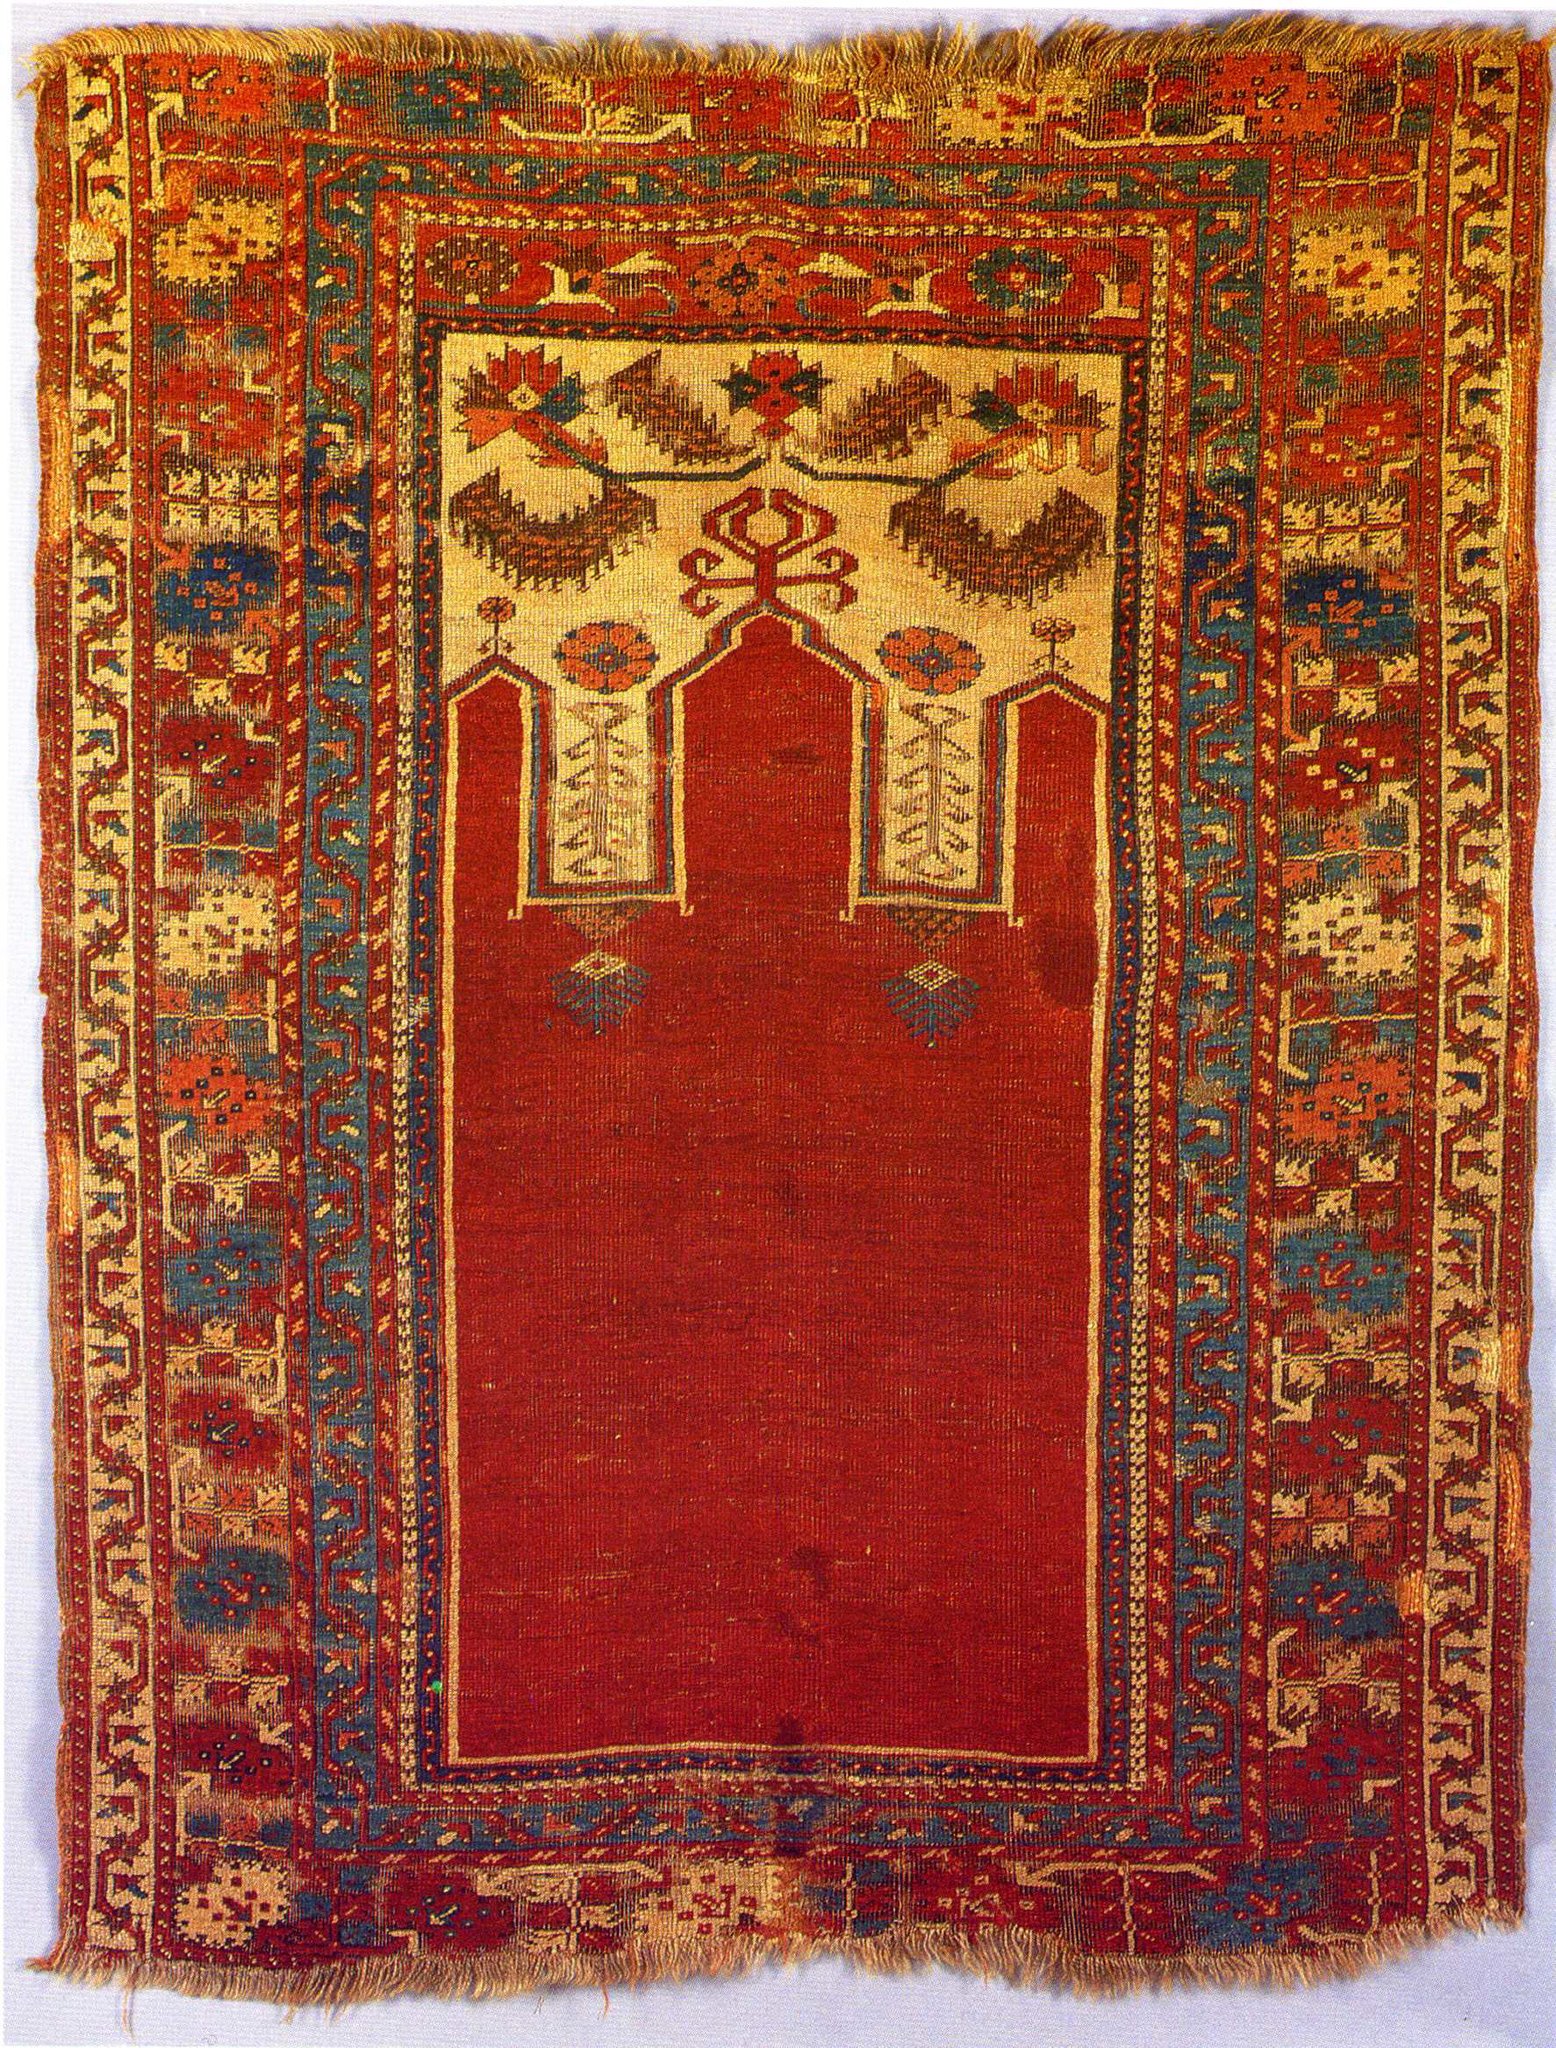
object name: carpet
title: Prayer Rug with Triple Arch Design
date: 1767-1800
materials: wool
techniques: pile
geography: turkey